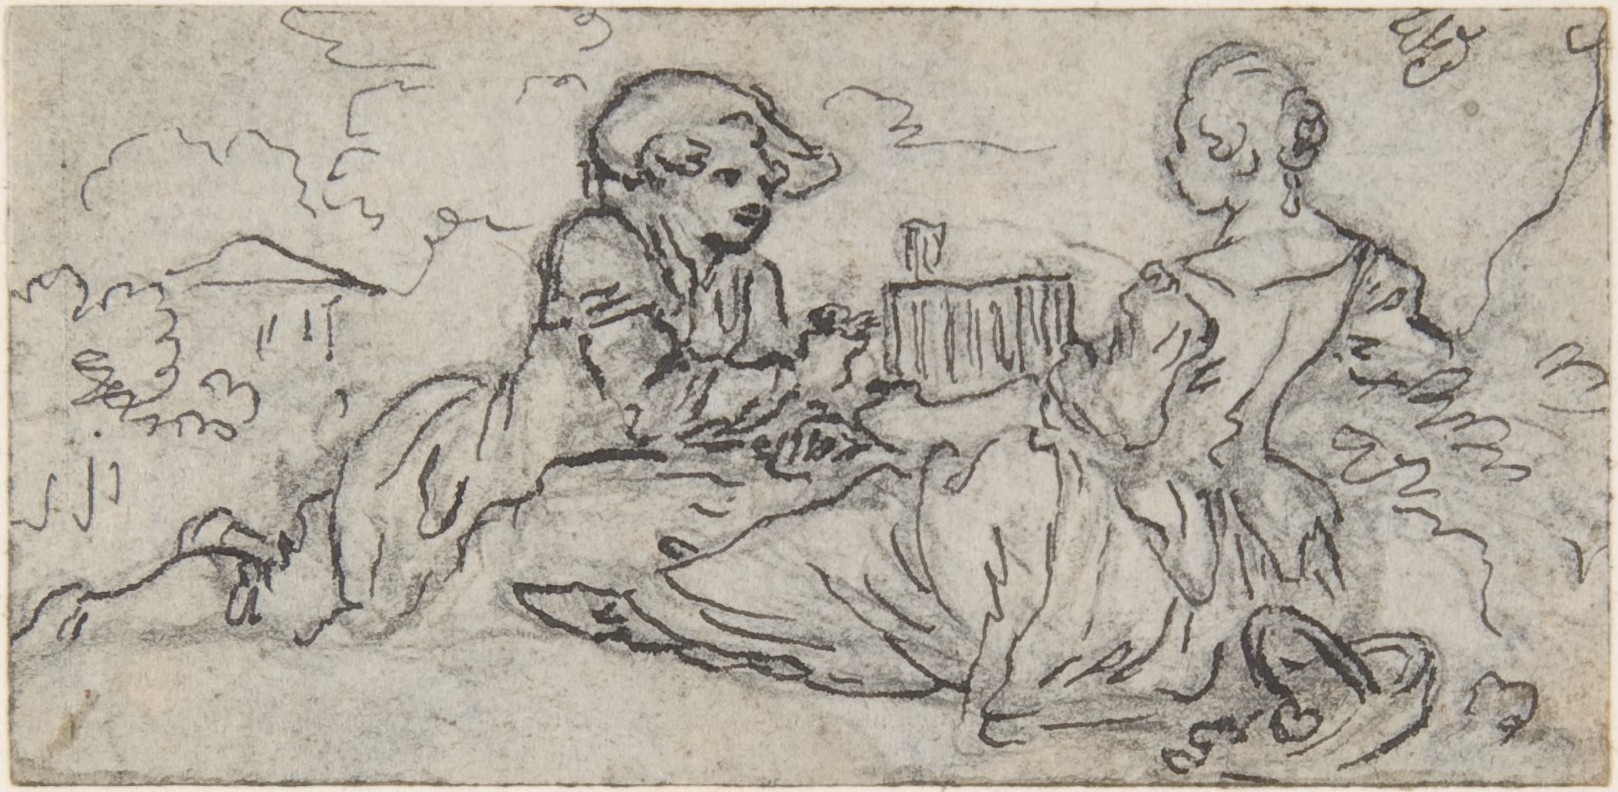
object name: drawing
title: Design for a Box-Lid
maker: hubert françois gravelot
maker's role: artist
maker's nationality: french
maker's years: 1699-1773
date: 1701-1800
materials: chalk, ink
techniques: pen, drawing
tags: men,women